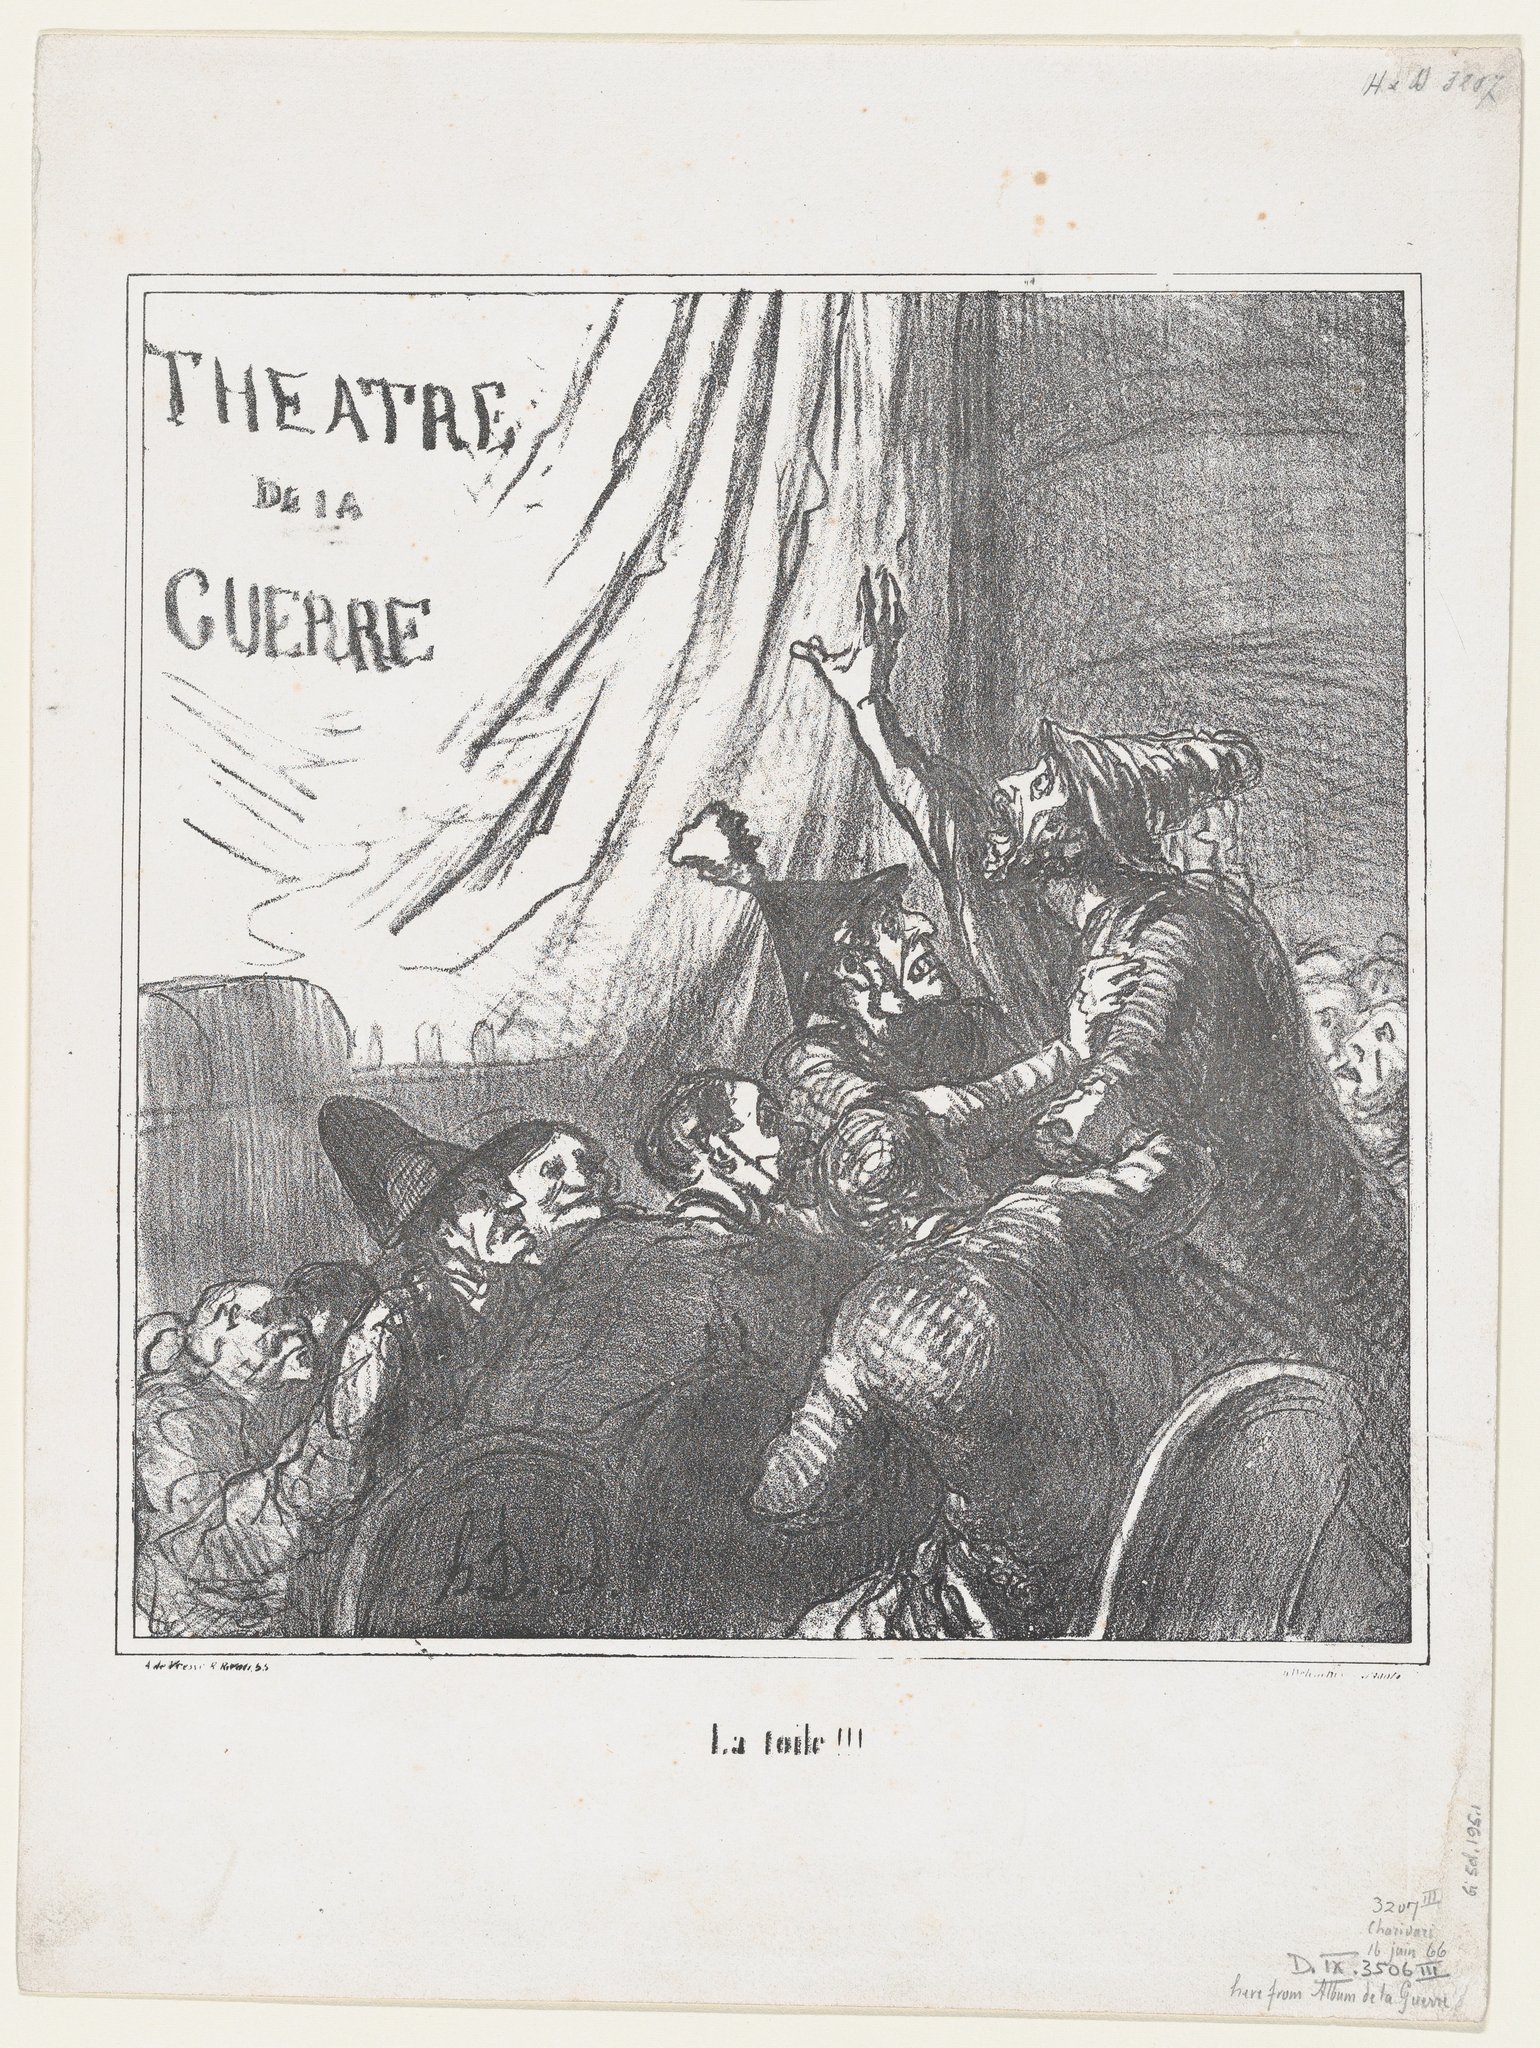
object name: print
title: Curtain!!!, from 'News of the day,' published in 'The war album'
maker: honoré daumier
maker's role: artist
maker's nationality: french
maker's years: 1808-1879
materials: paper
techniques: lithograph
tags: men,crowd